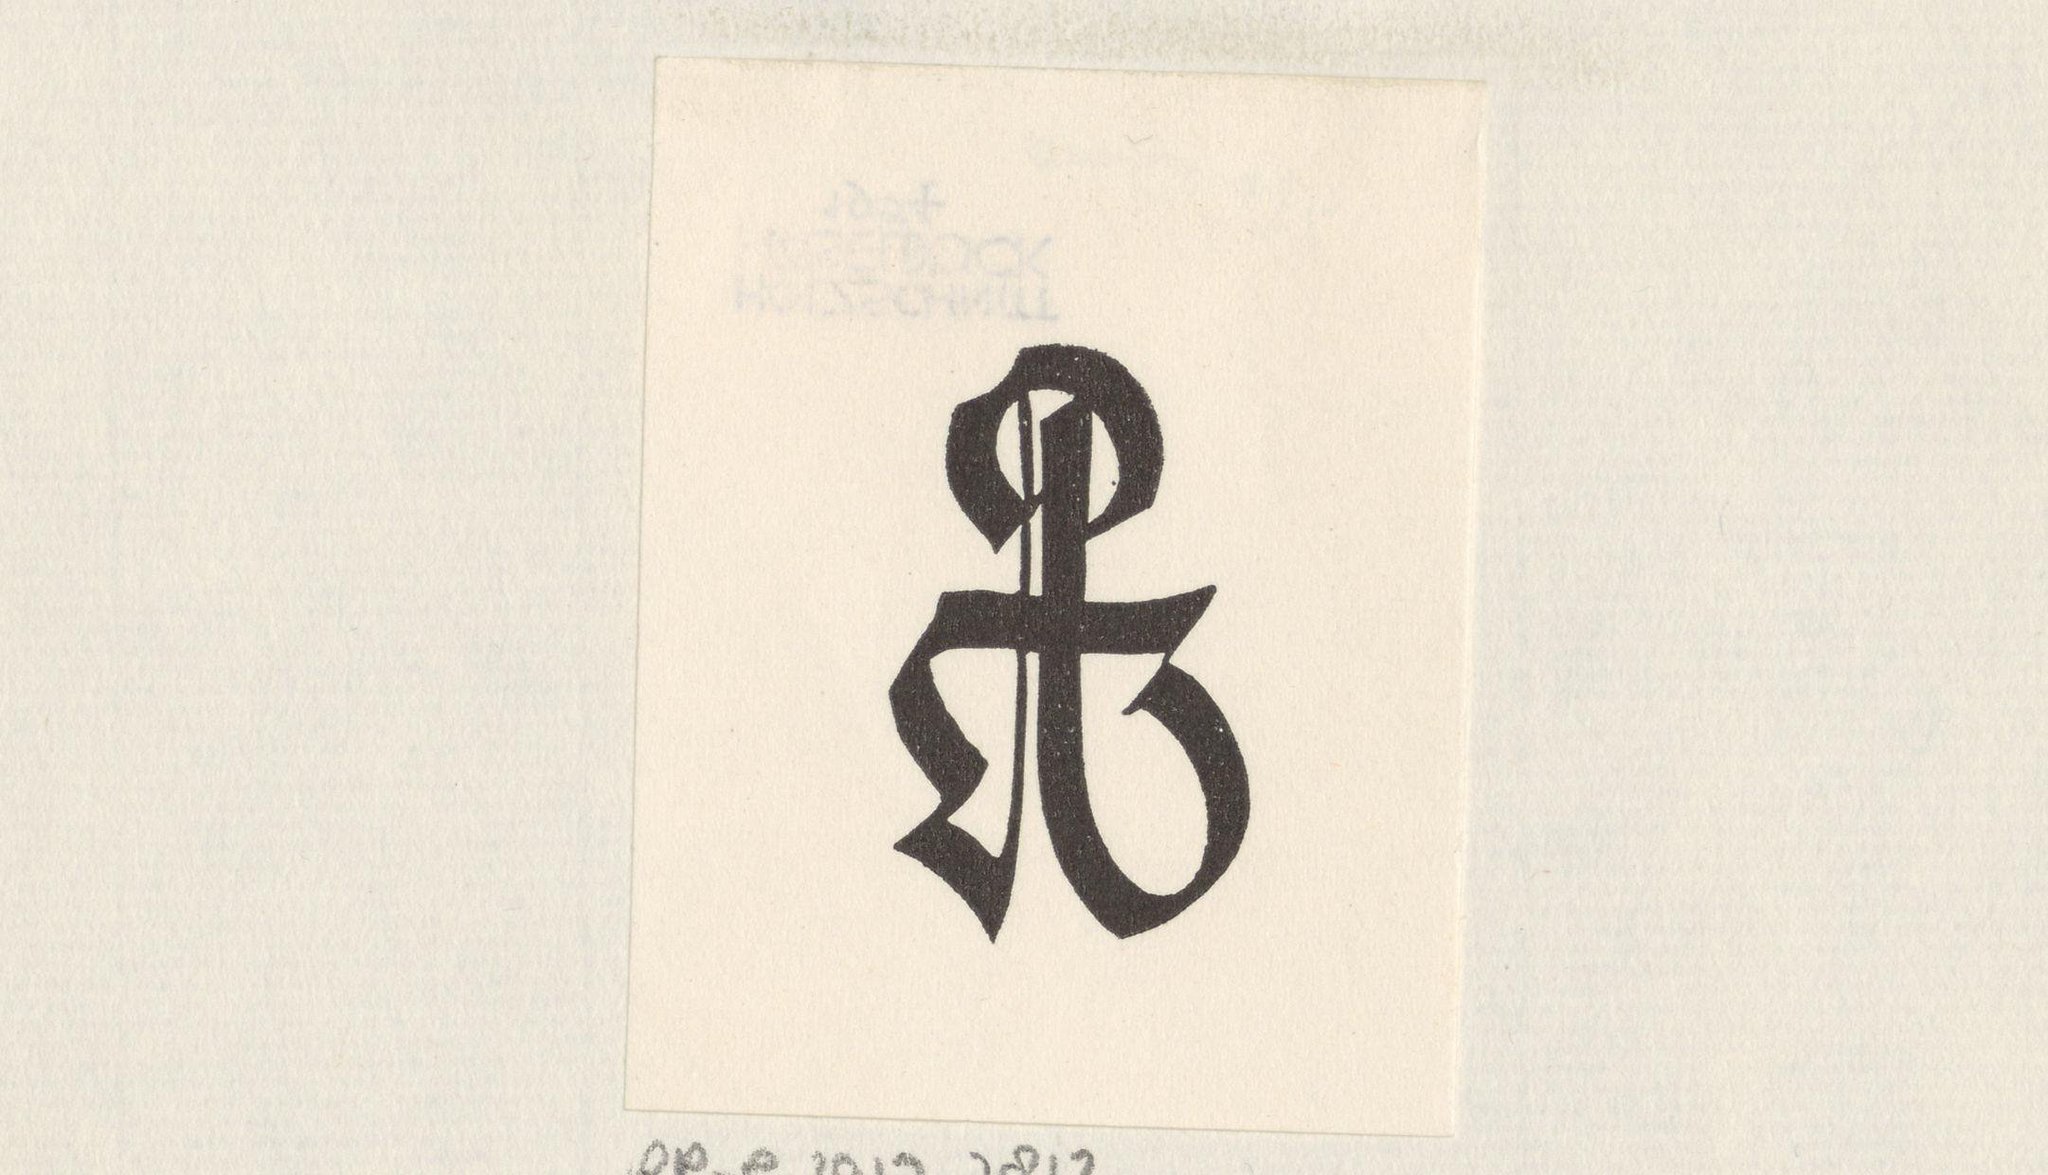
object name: bookplate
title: Ex libris van onbekend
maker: karl haselböck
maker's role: print maker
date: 1954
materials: paper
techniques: woodcut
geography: austria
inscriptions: workshop stamp: ‘Holzschnitt/ Haselböck/ 1954’